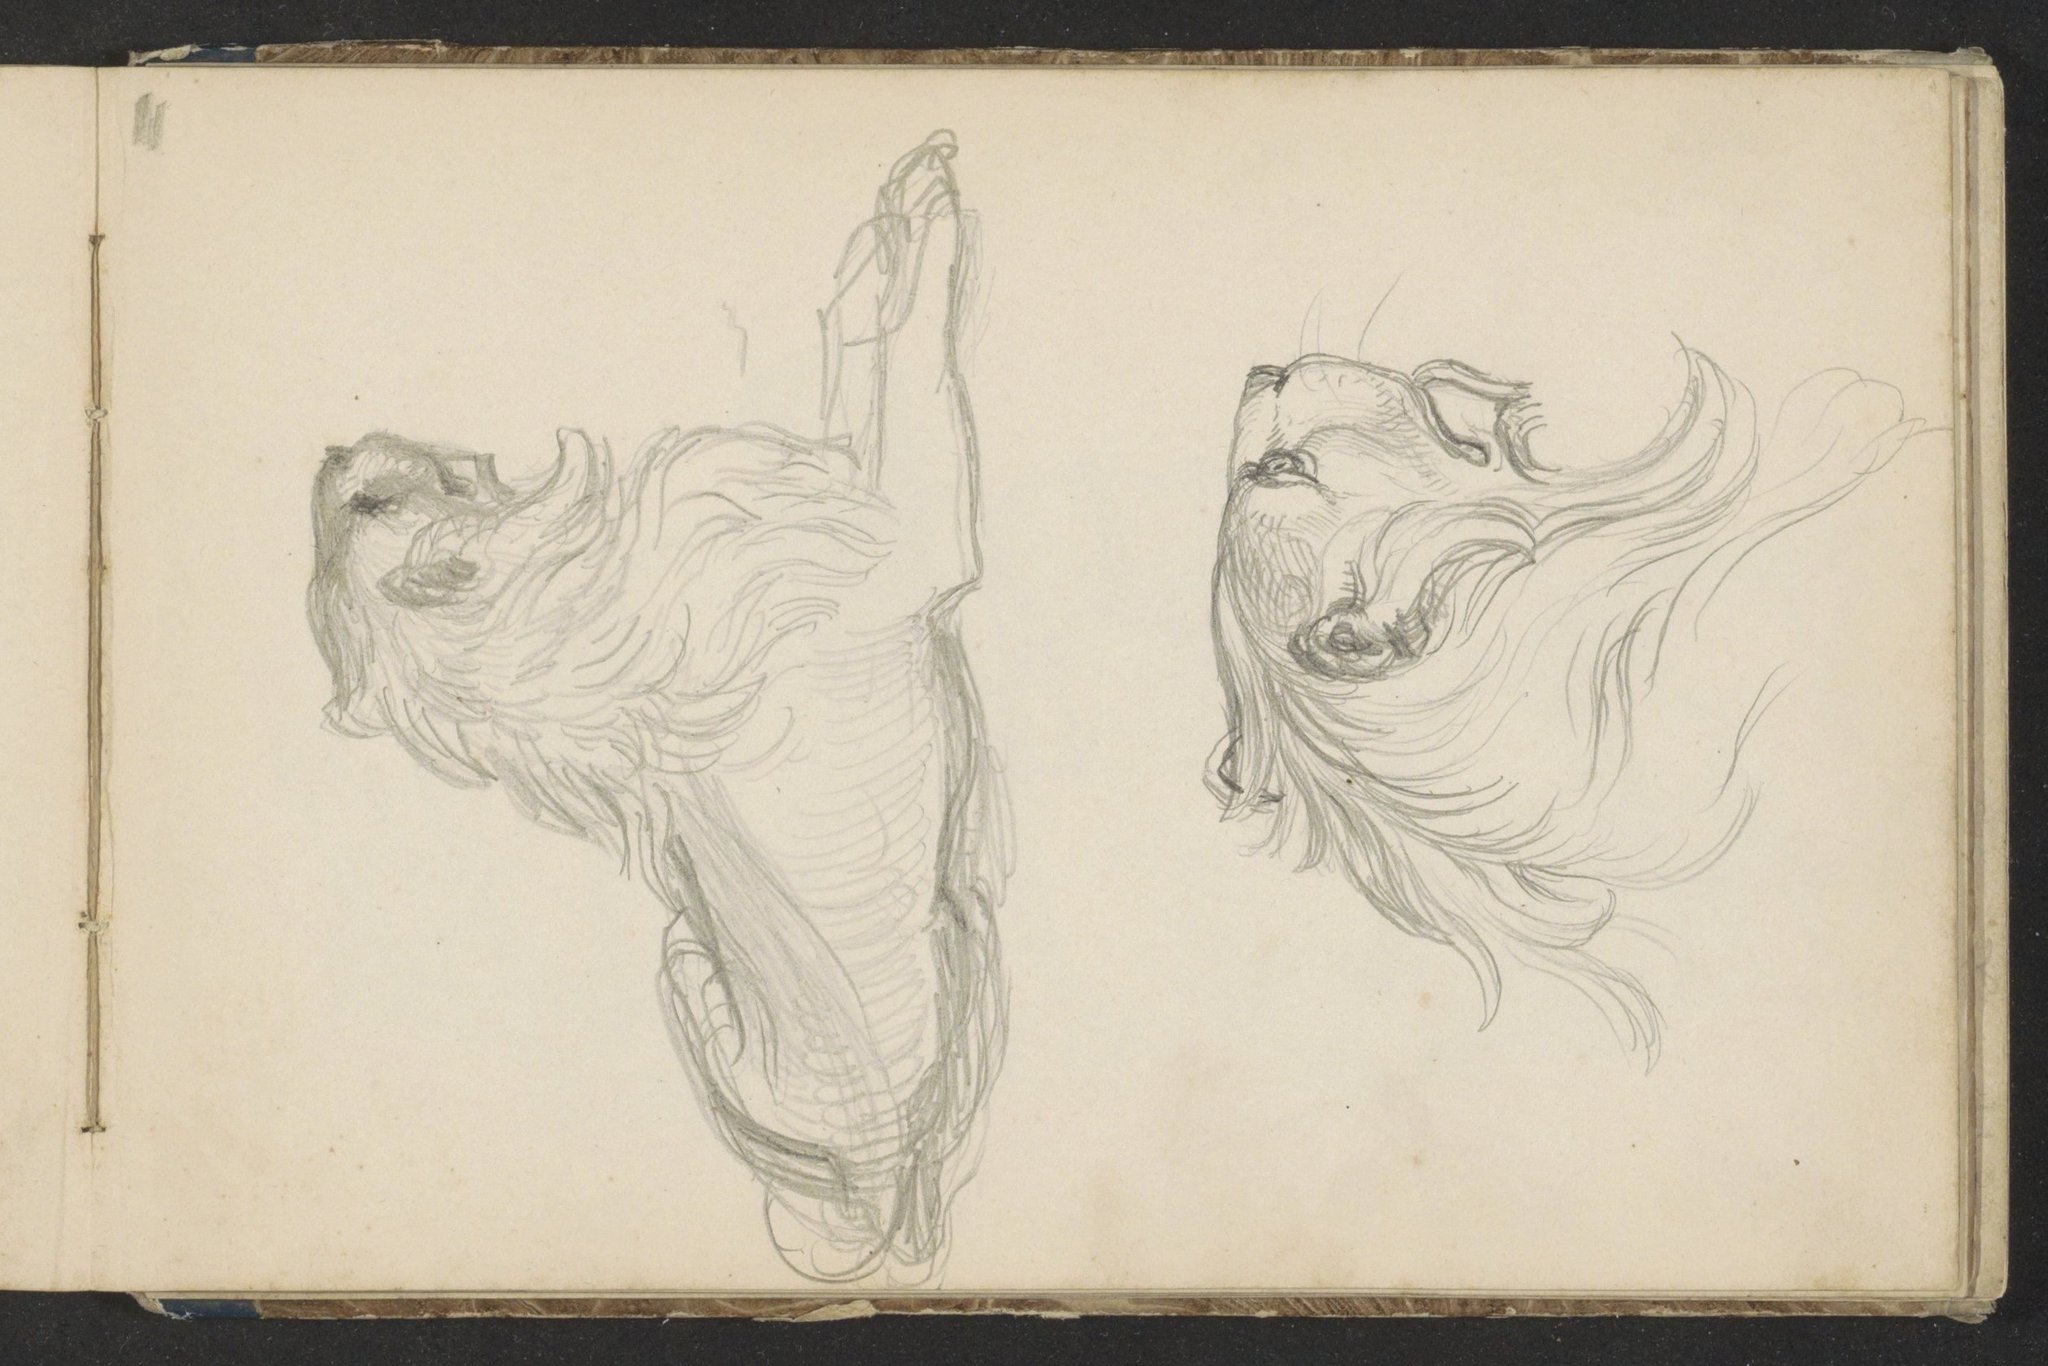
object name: sketchbook leaf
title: Leeuw en een leeuwenkop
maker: Anonymous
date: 1841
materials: paper, pencil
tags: beasts of prey, predatory animals: lion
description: Blad 11 recto uit een schetsboek met 33 bladen.